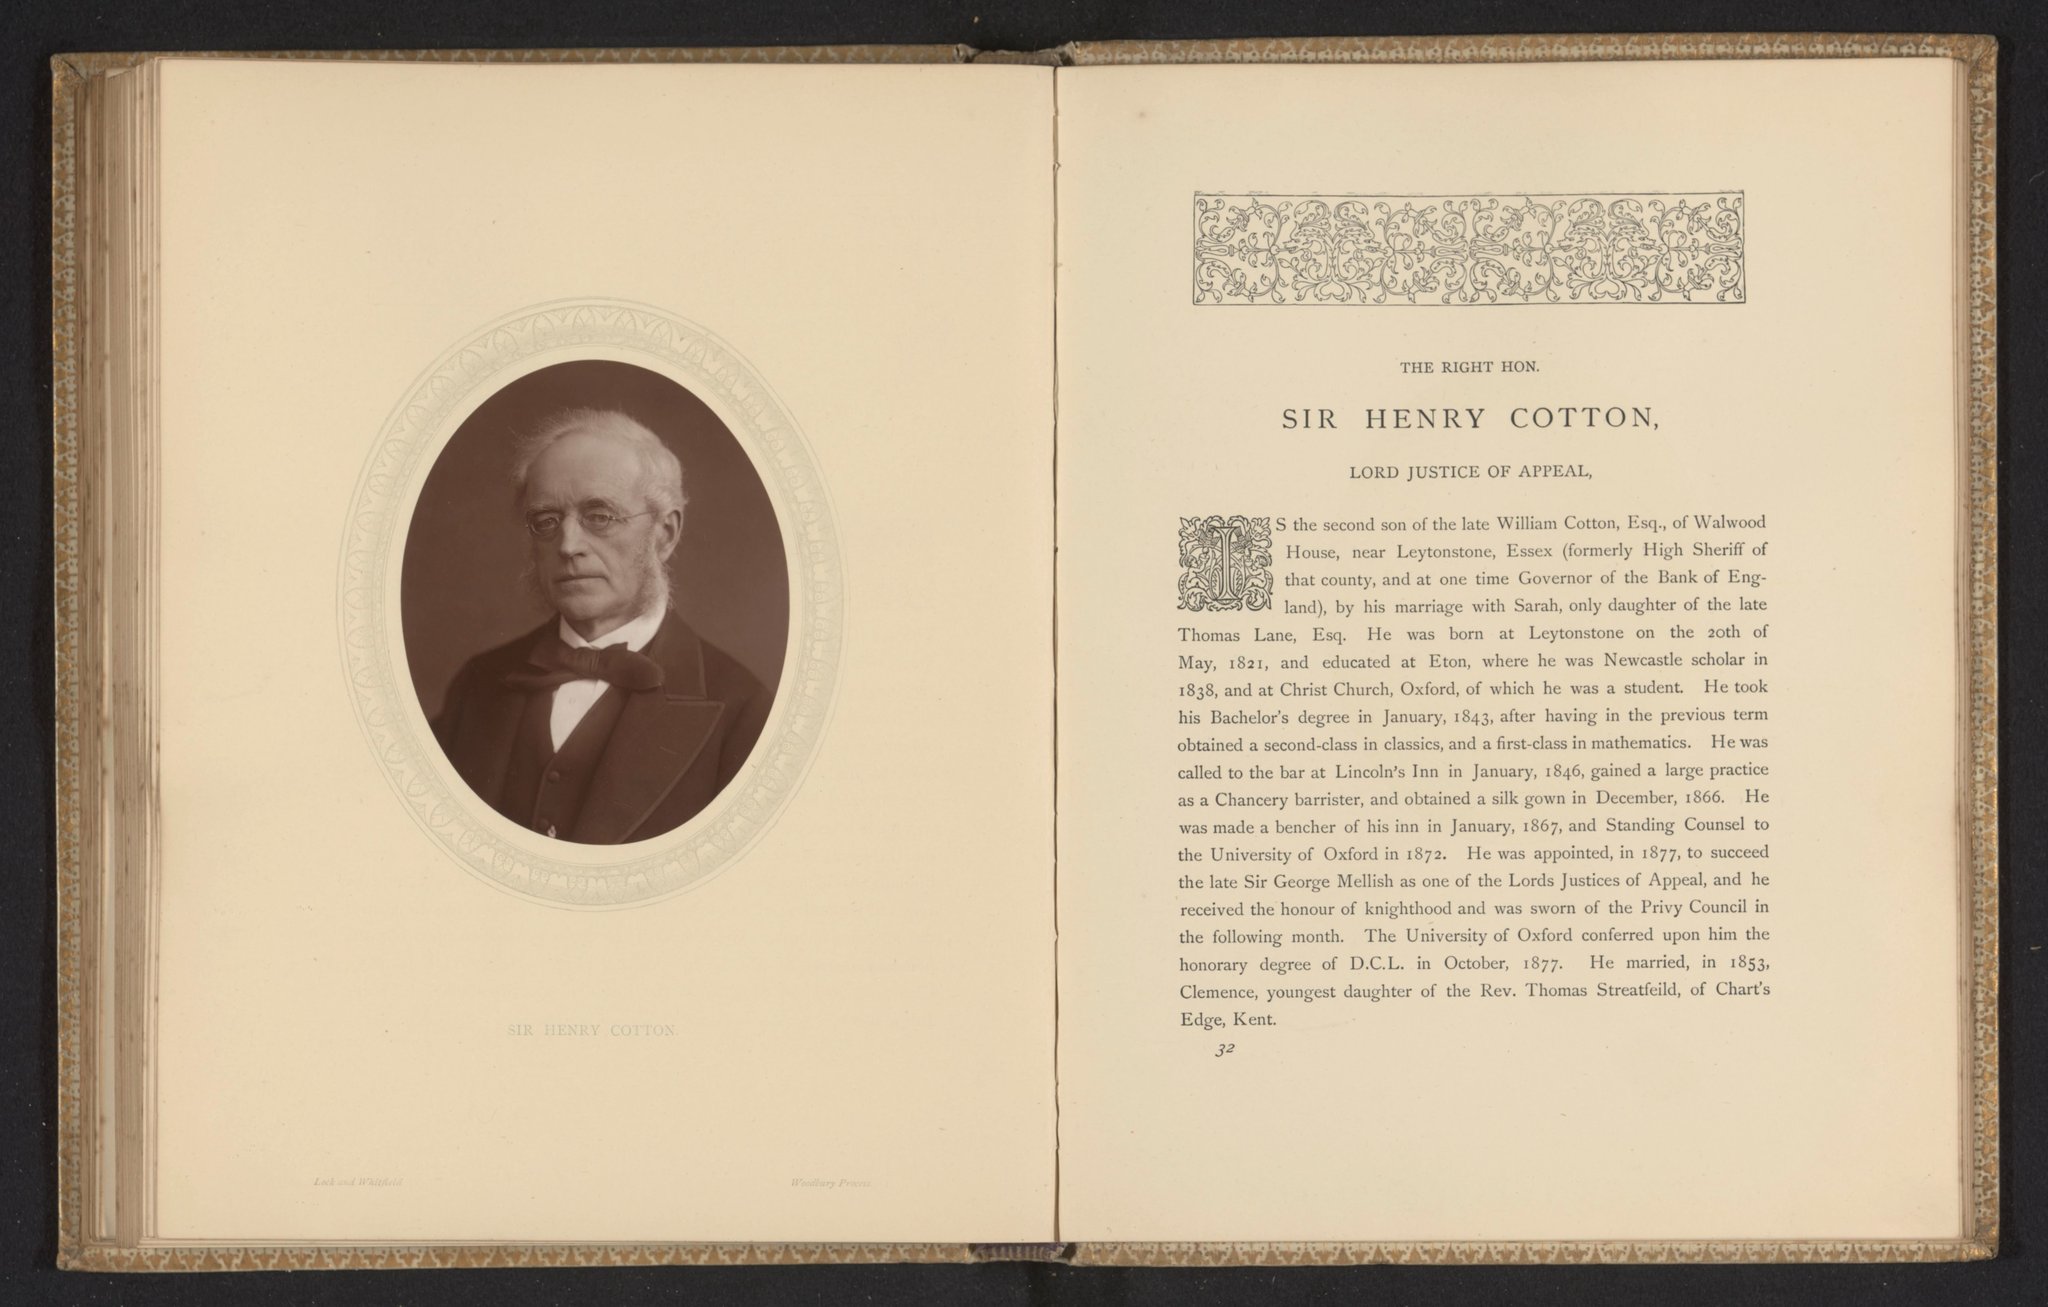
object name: page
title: Sir Henry Cotton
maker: Anonymous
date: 1876-1881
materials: paper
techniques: woodburytype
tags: historical persons (portraits and scenes from the life) (+ (full) bust portrait), magistracy, judges